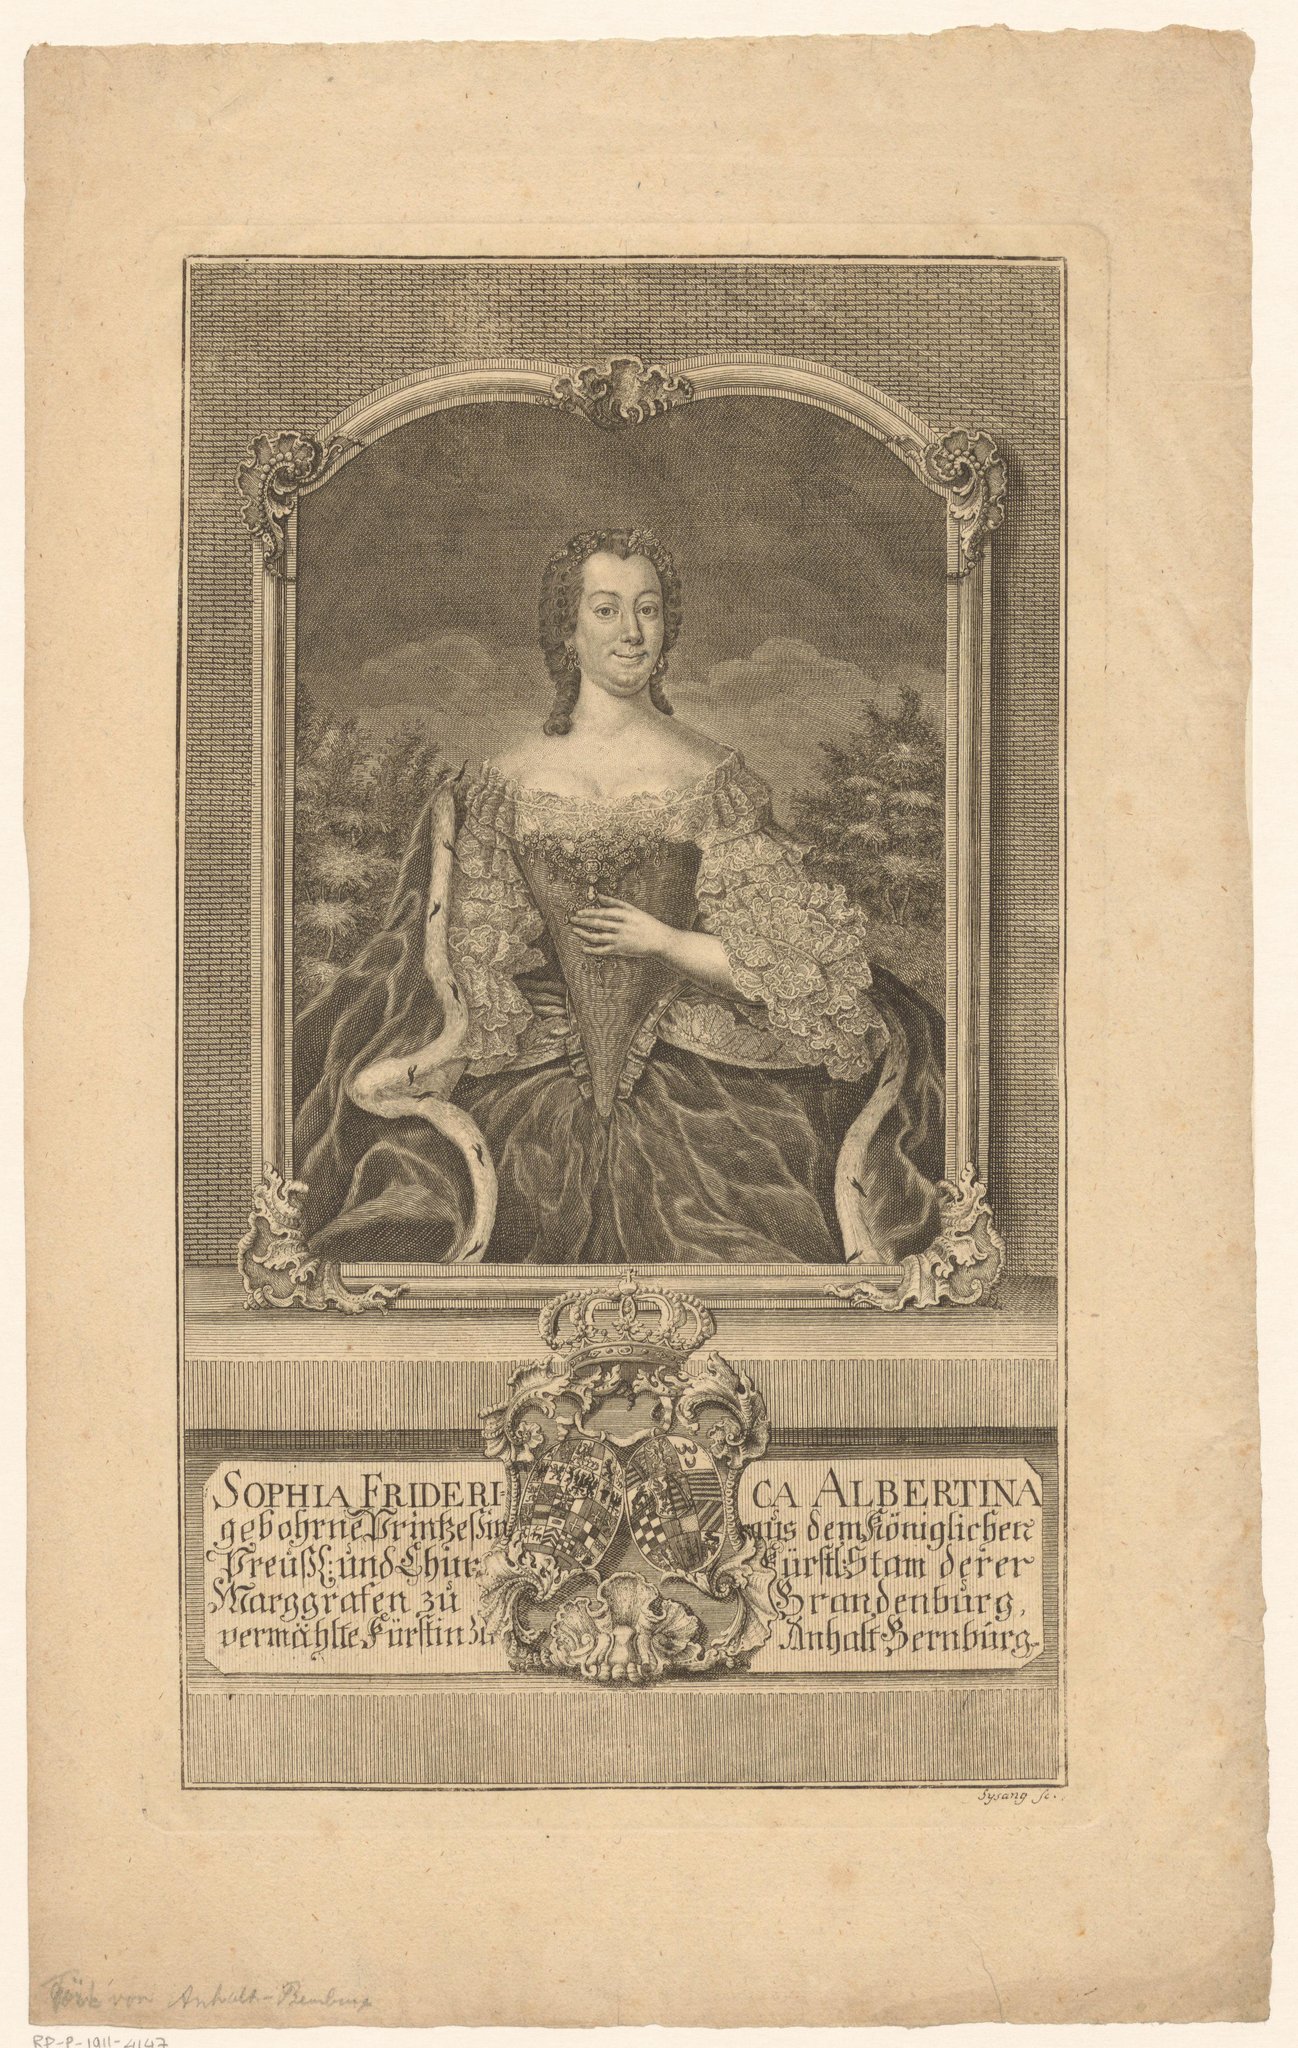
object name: print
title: Portret van Sophie Friederike Albertine von Brandenburg-Schwedt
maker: johann christoph sysang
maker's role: print maker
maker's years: 1703-1757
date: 1733-1757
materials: paper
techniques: engraving, etching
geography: germany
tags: berlin, historical persons - bb - woman, armorial bearing, heraldry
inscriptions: collector's mark: Lugt 2228